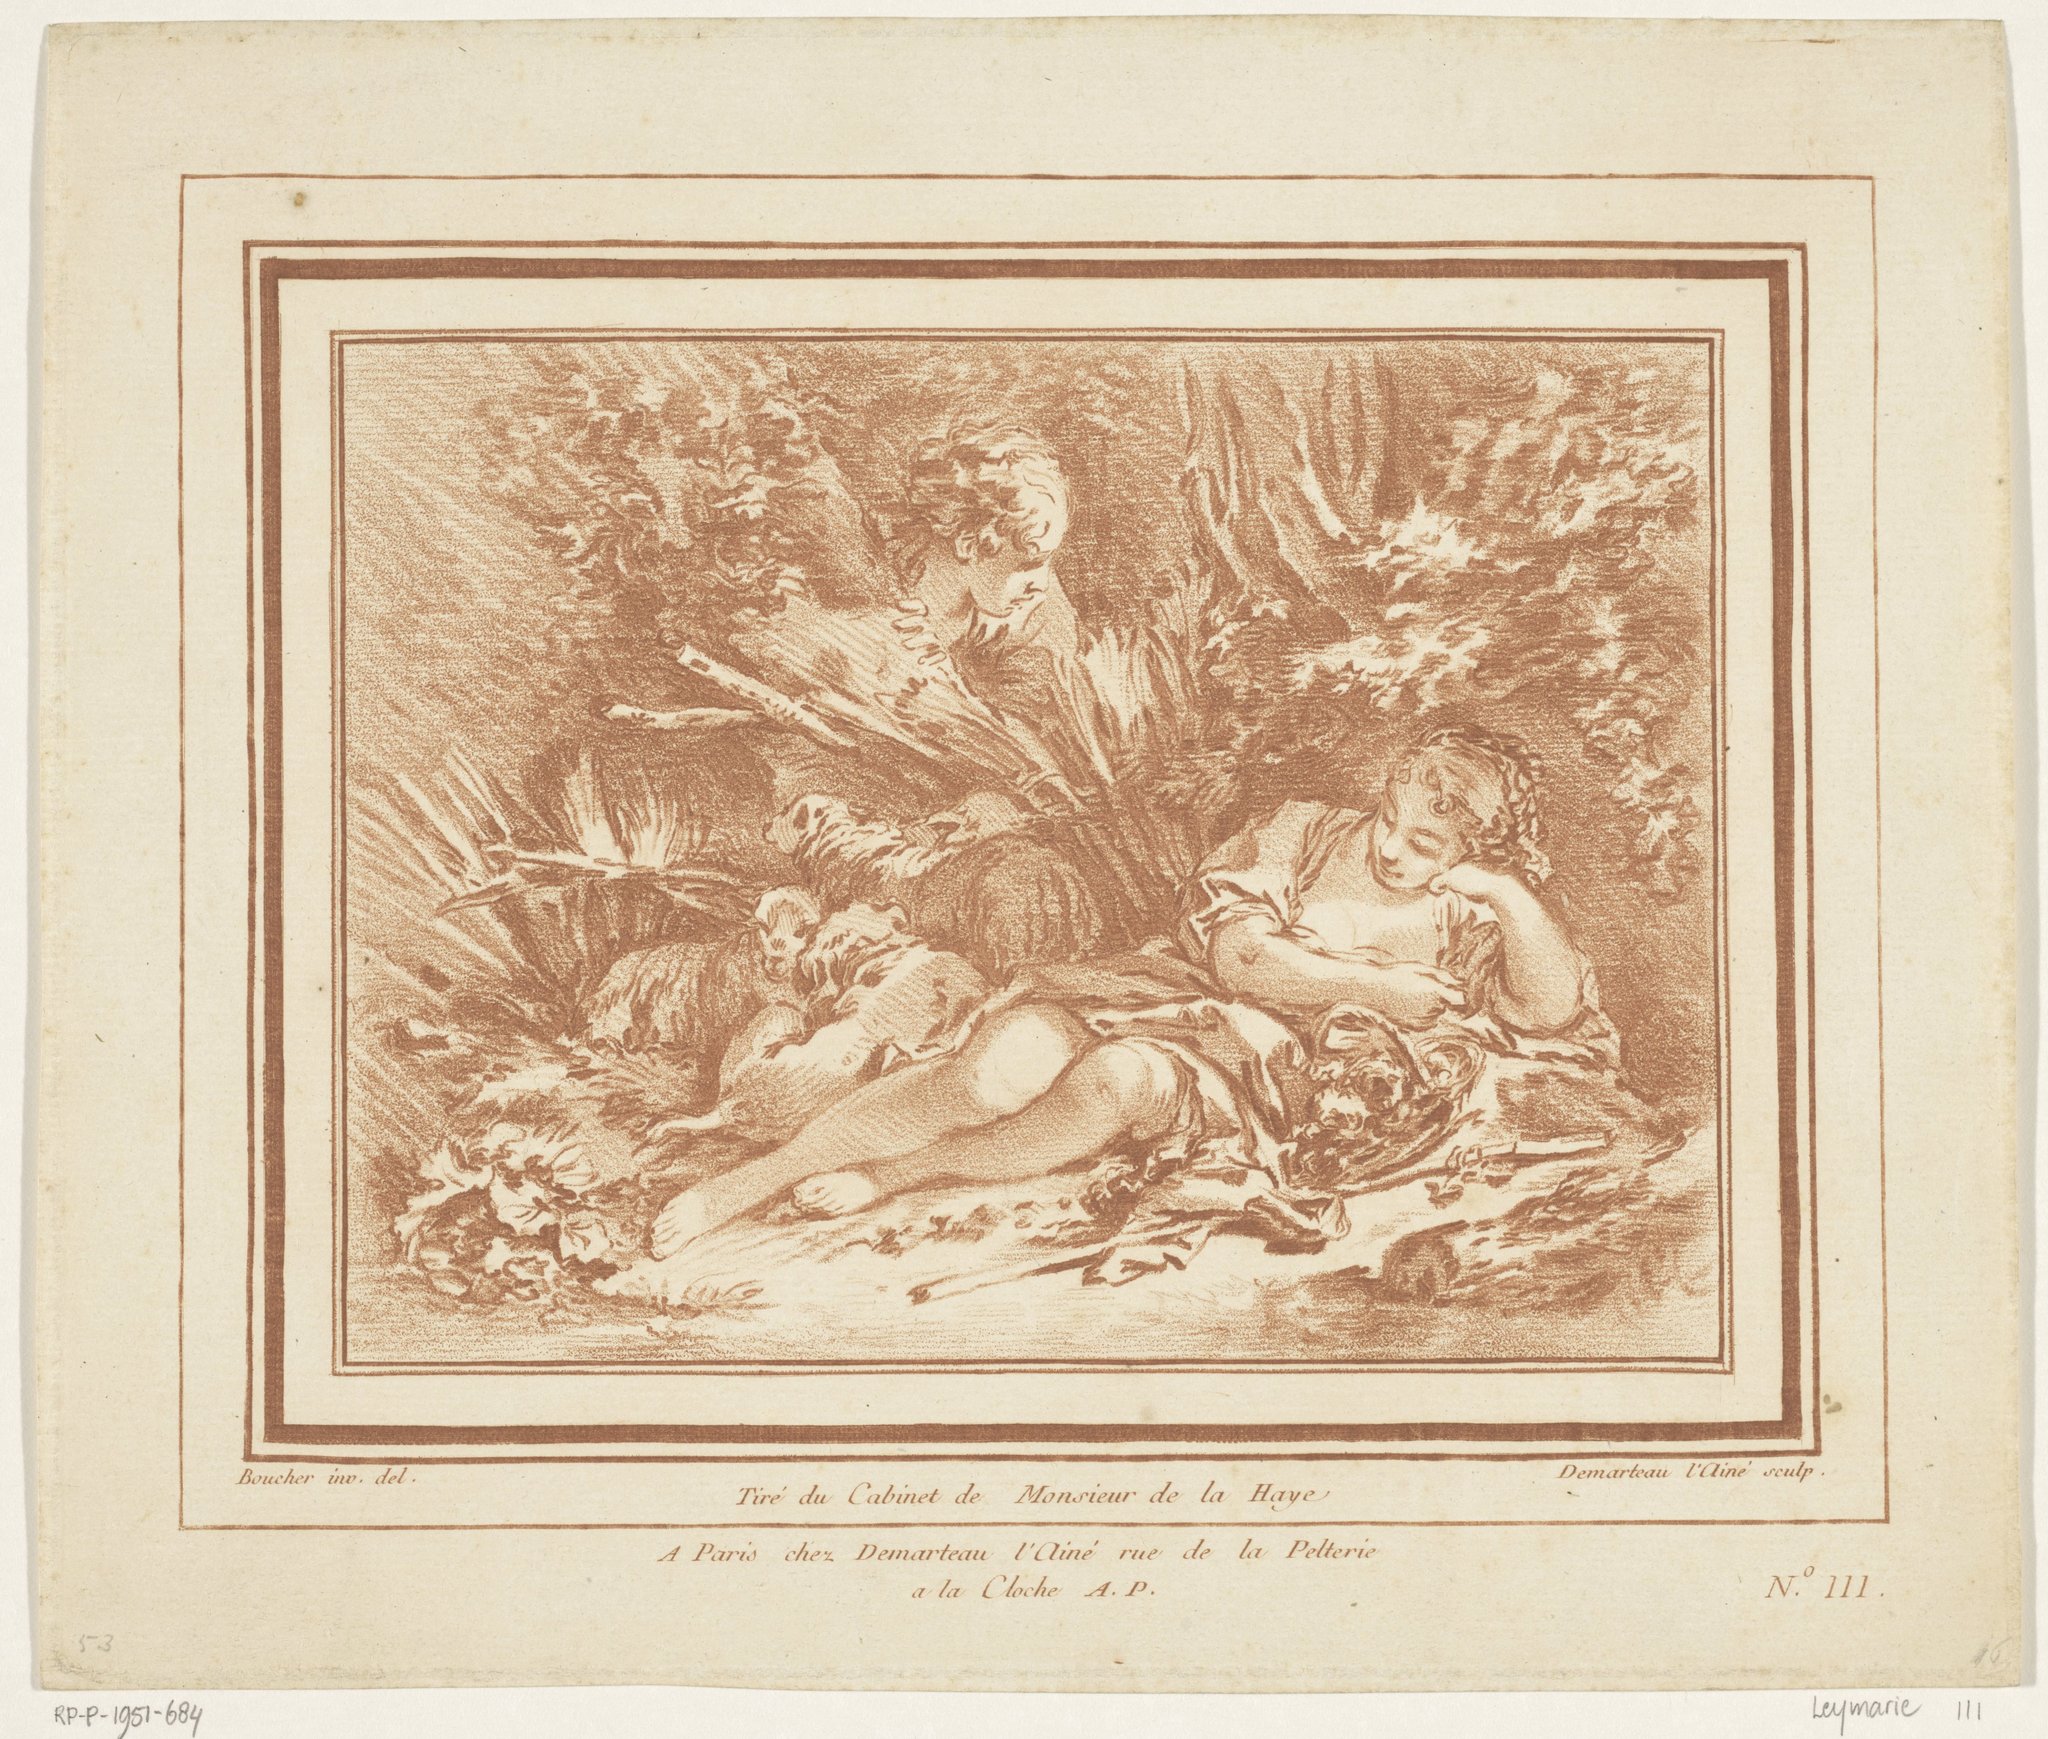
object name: print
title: Liggende herderin met schapen en herder met fluit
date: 1732-1776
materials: paper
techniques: printmaking, etching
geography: paris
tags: herding, herdsman, herdswoman, shepherd, shepherdess, cowherd, etc., pastorals, arcadian scenes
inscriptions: collector's mark: Lugt 2228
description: Naar tekening van Francois Boucher in de collectie van de heer De la Haye, aldus opschrift.